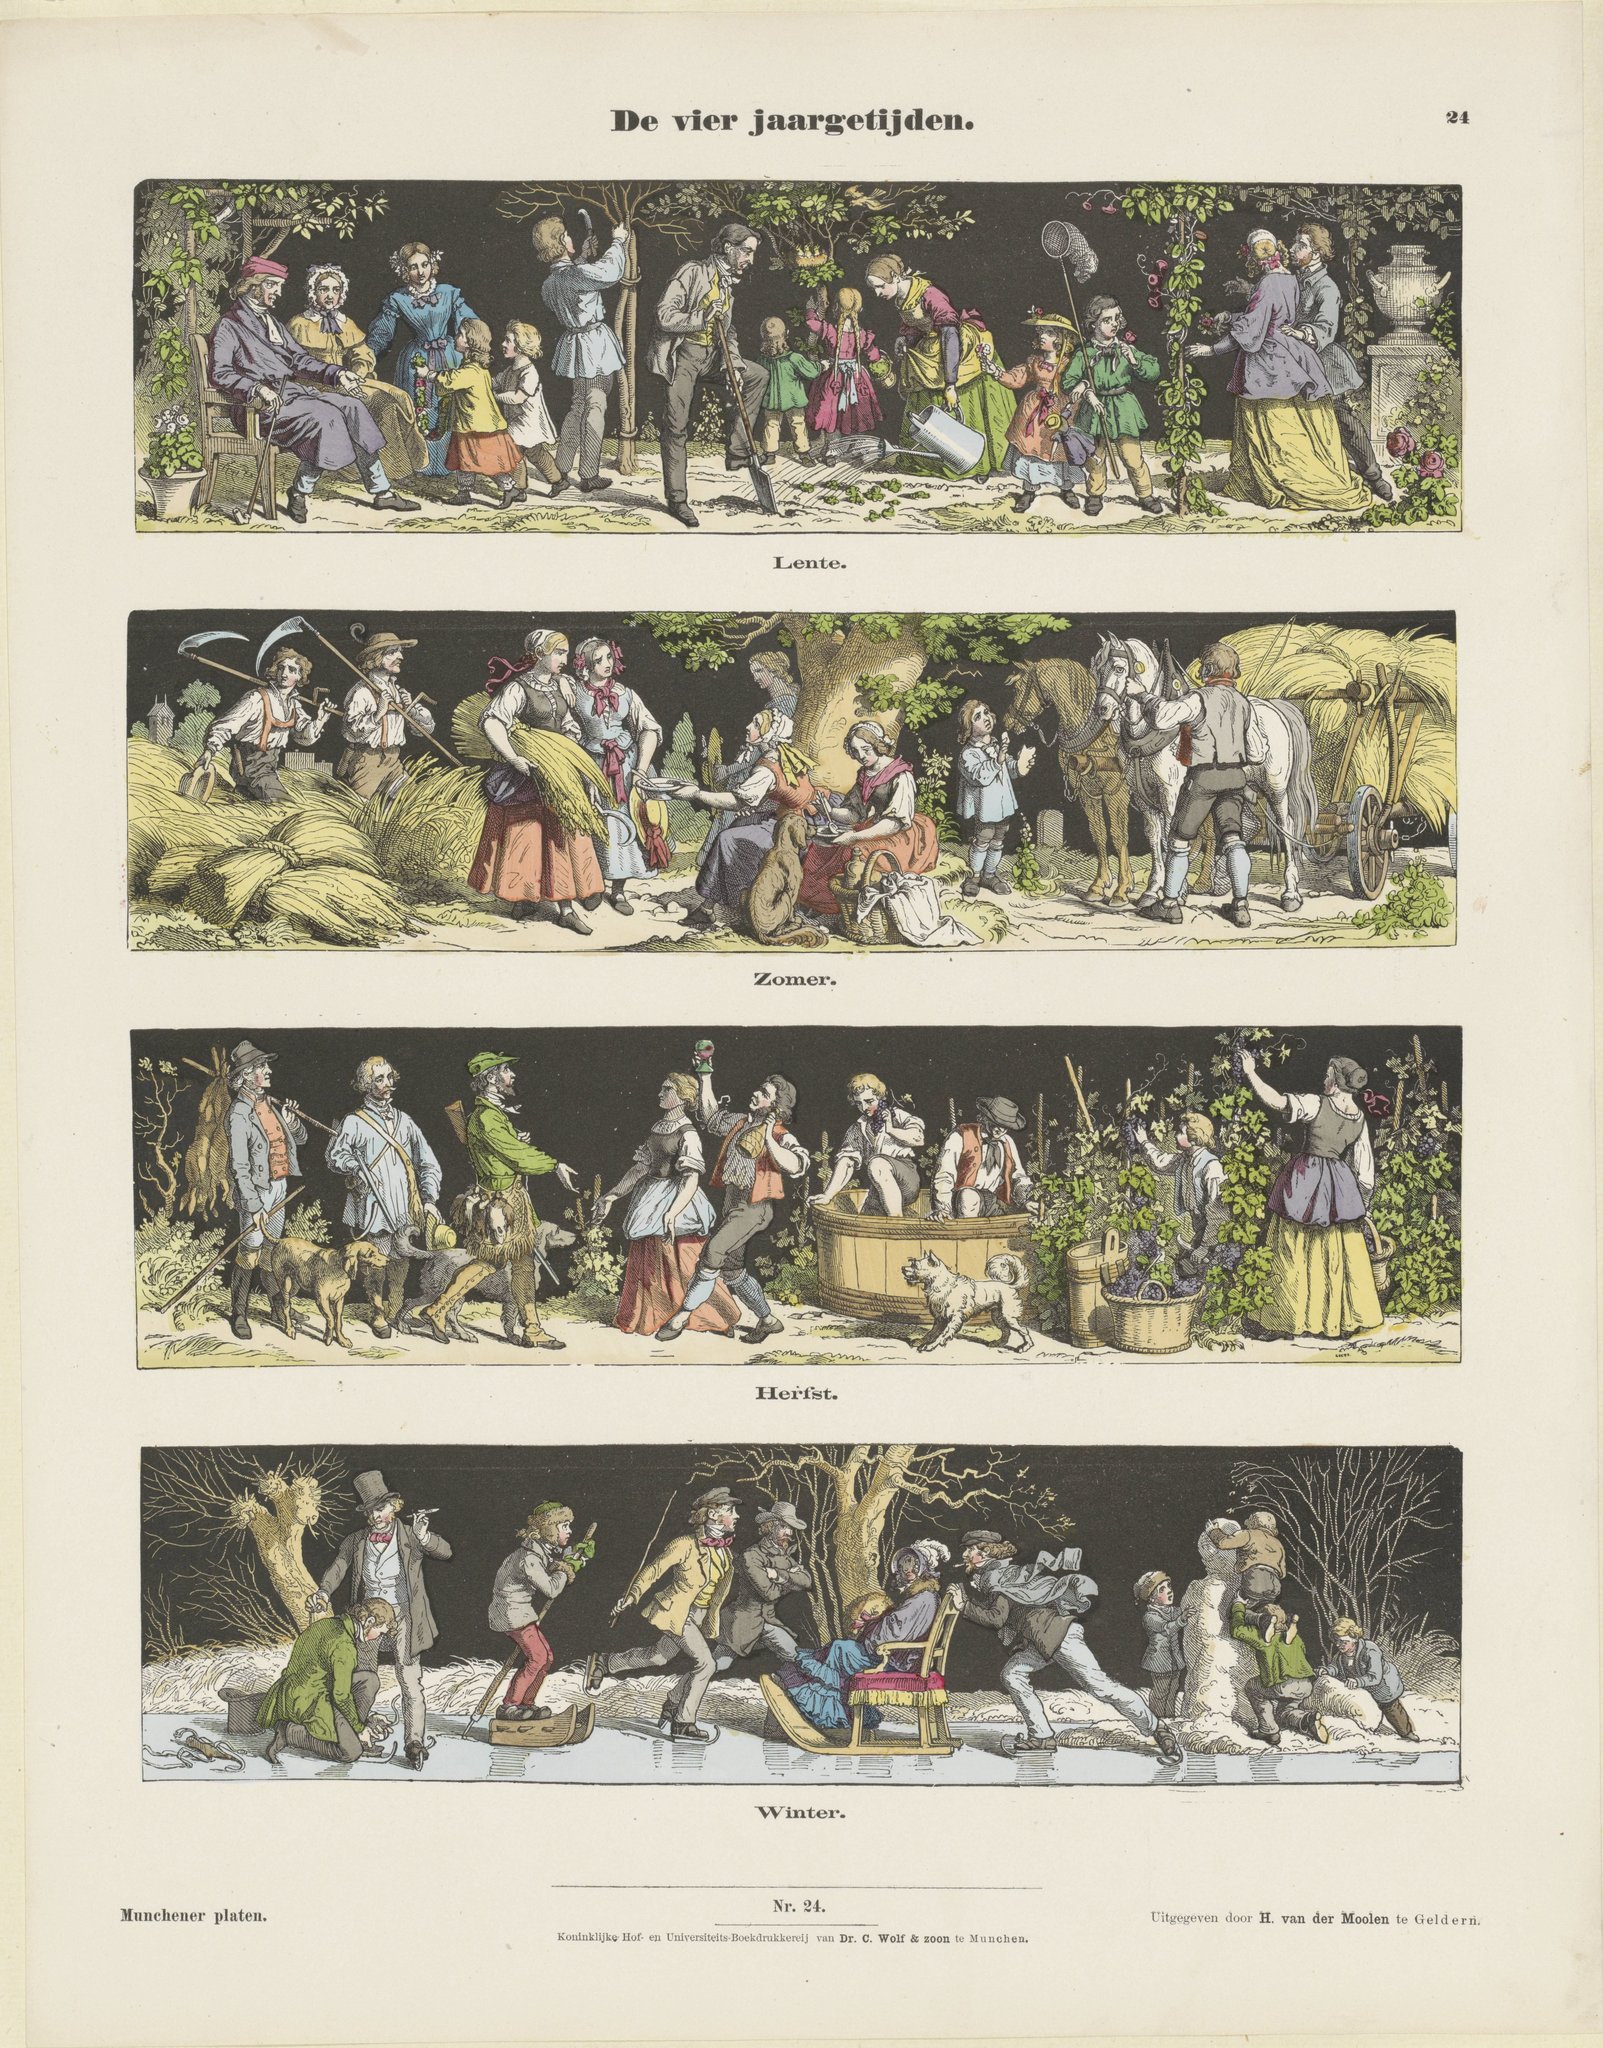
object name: print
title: Munchener platen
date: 1843-1920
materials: paper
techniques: colour, letterpress printing, engraving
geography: geldern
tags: the four seasons of the year ~ human activities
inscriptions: collector's mark: Lugt 2760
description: Blad met 4 horizontale rijen met voorstellingen van de vier jaargetijden uitgebeeld door typische activiteiten per seizoen, tegen een zwarte achtergrond. Onder elke afbeelding de naam van het seizoen. Genummerd midden onder: Nr. 24. Genummerd rechtsboven: 24.